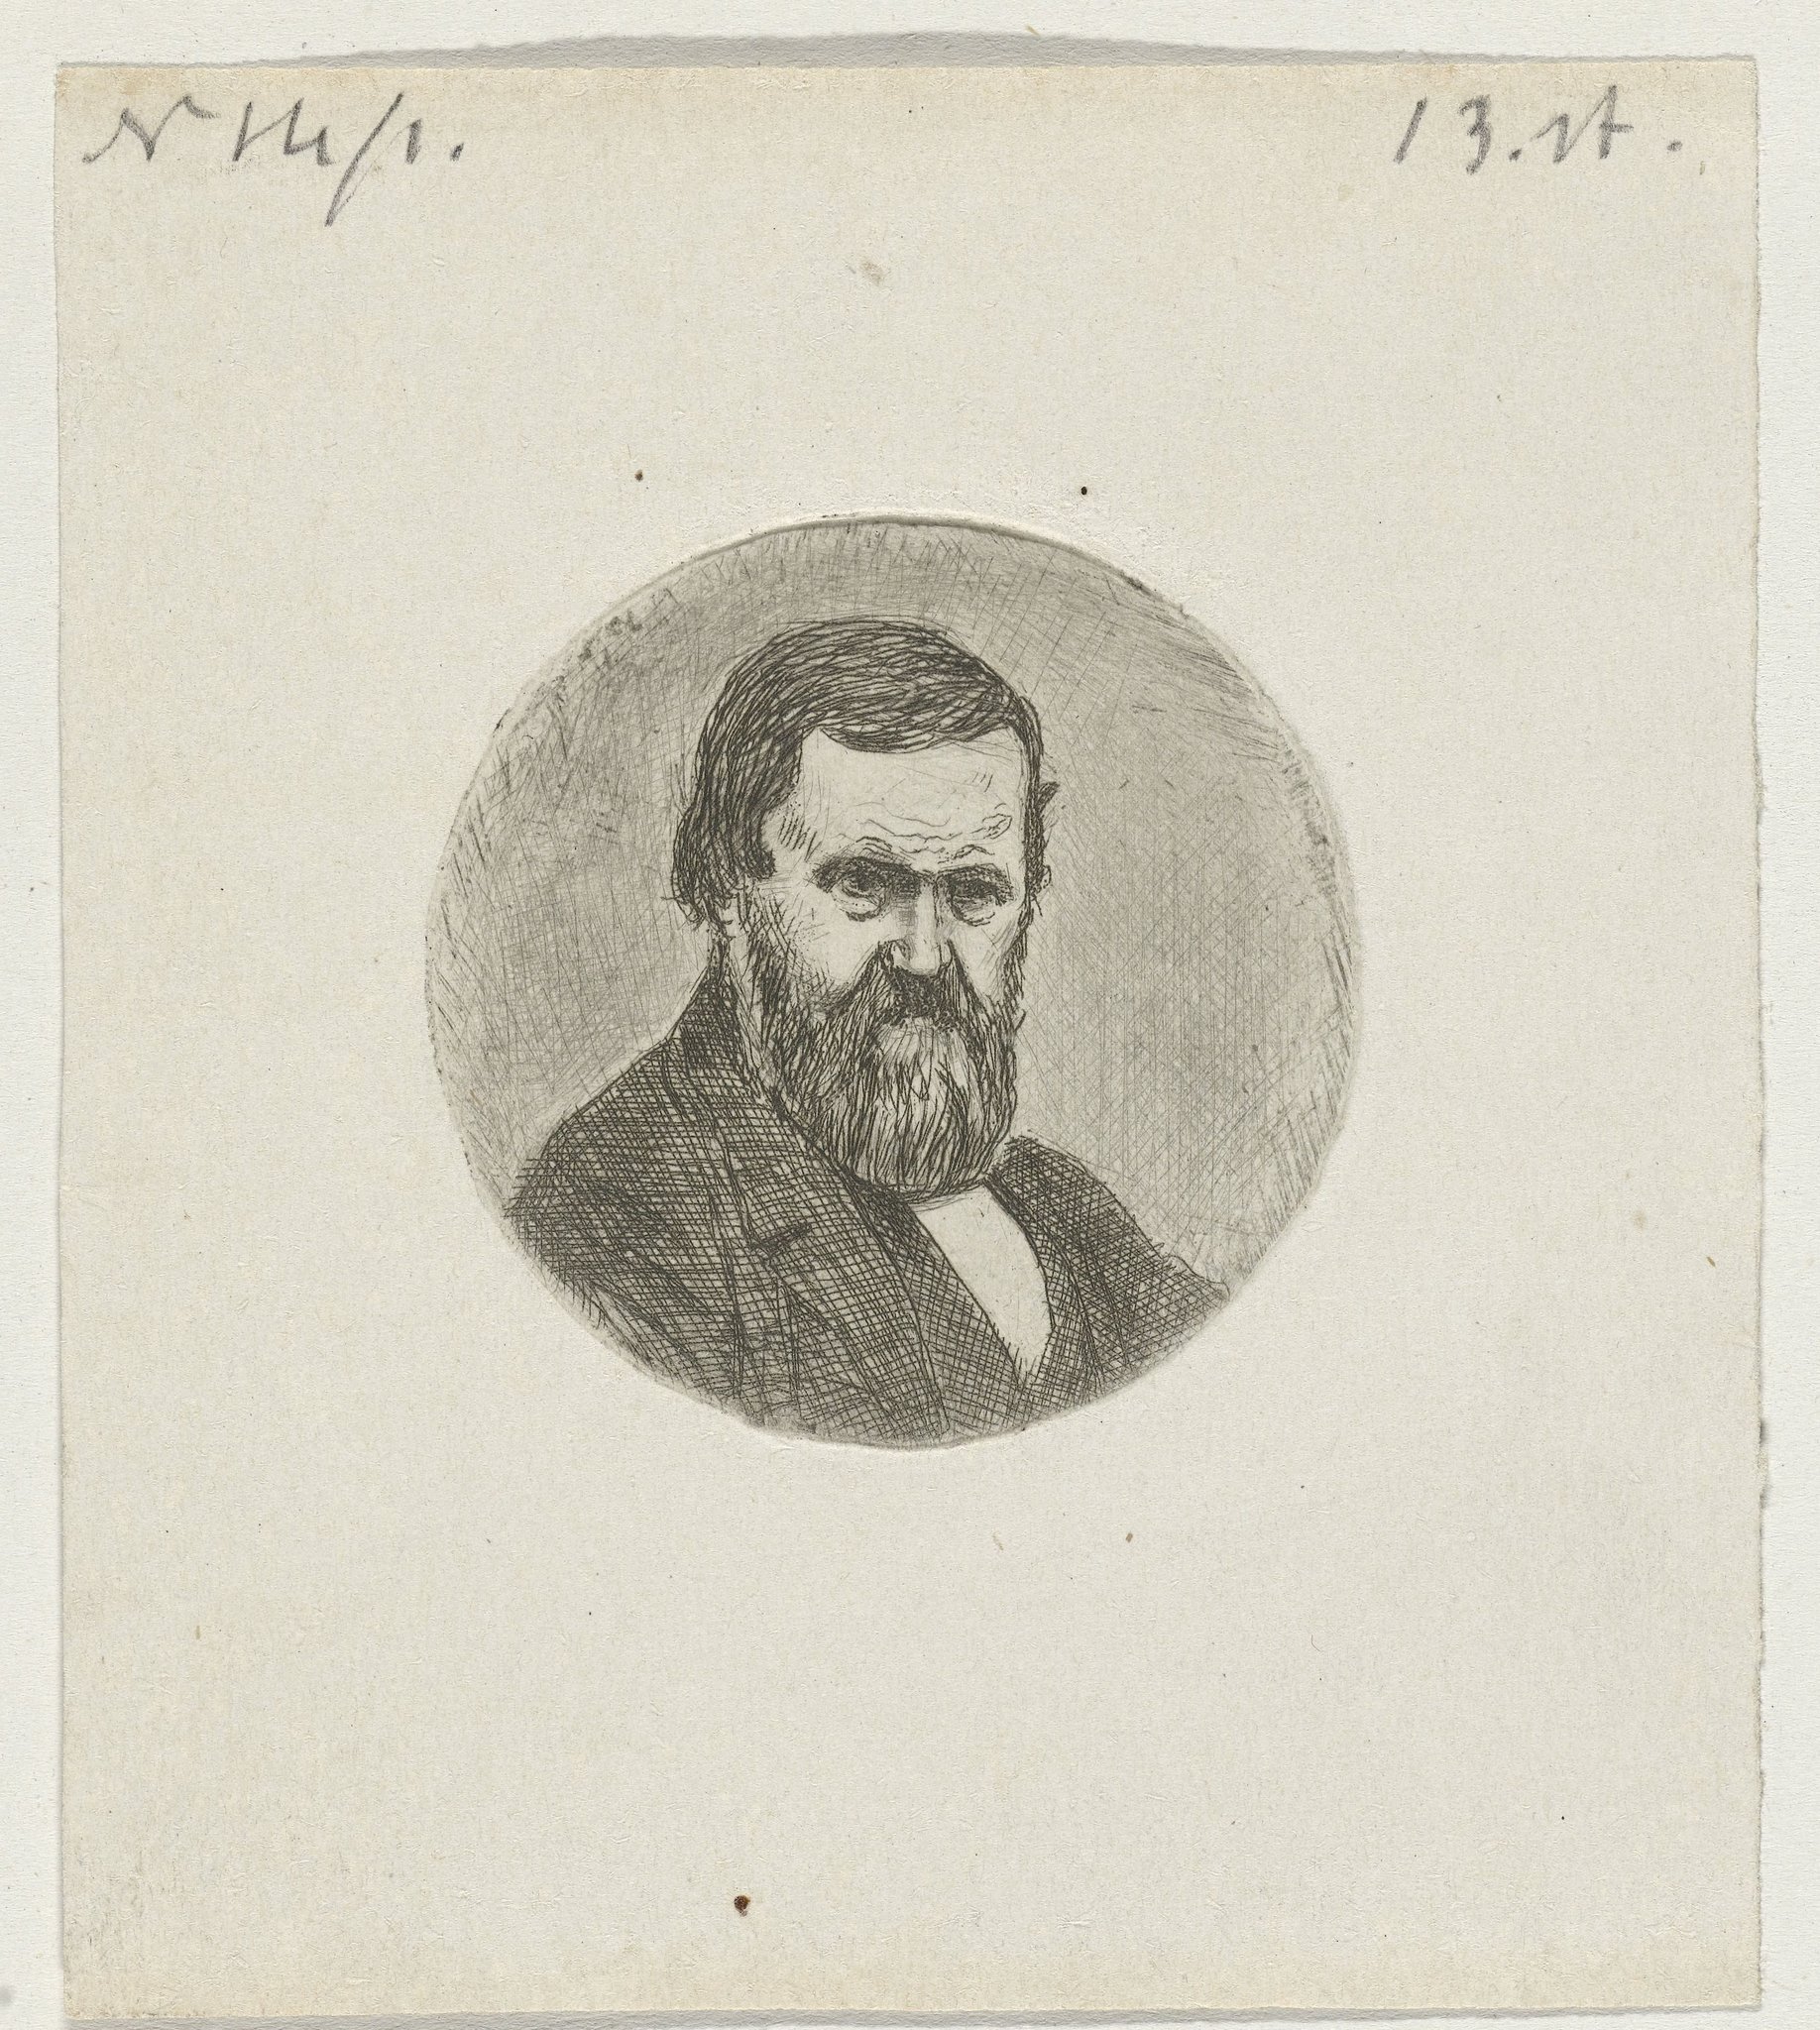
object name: print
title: Portret van Cornelis Ouboter van der Grient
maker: cornelis van der griendt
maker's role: draughtsman, painter, print maker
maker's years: 1827-1918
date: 1865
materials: paper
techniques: etching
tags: rotterdam, overschie, print maker, cornelis ouboter van der griendt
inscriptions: collector's mark: Lugt 2228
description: Portret in een ovaal van Cornelis Ouboter van der Grient, ten halven lijve.